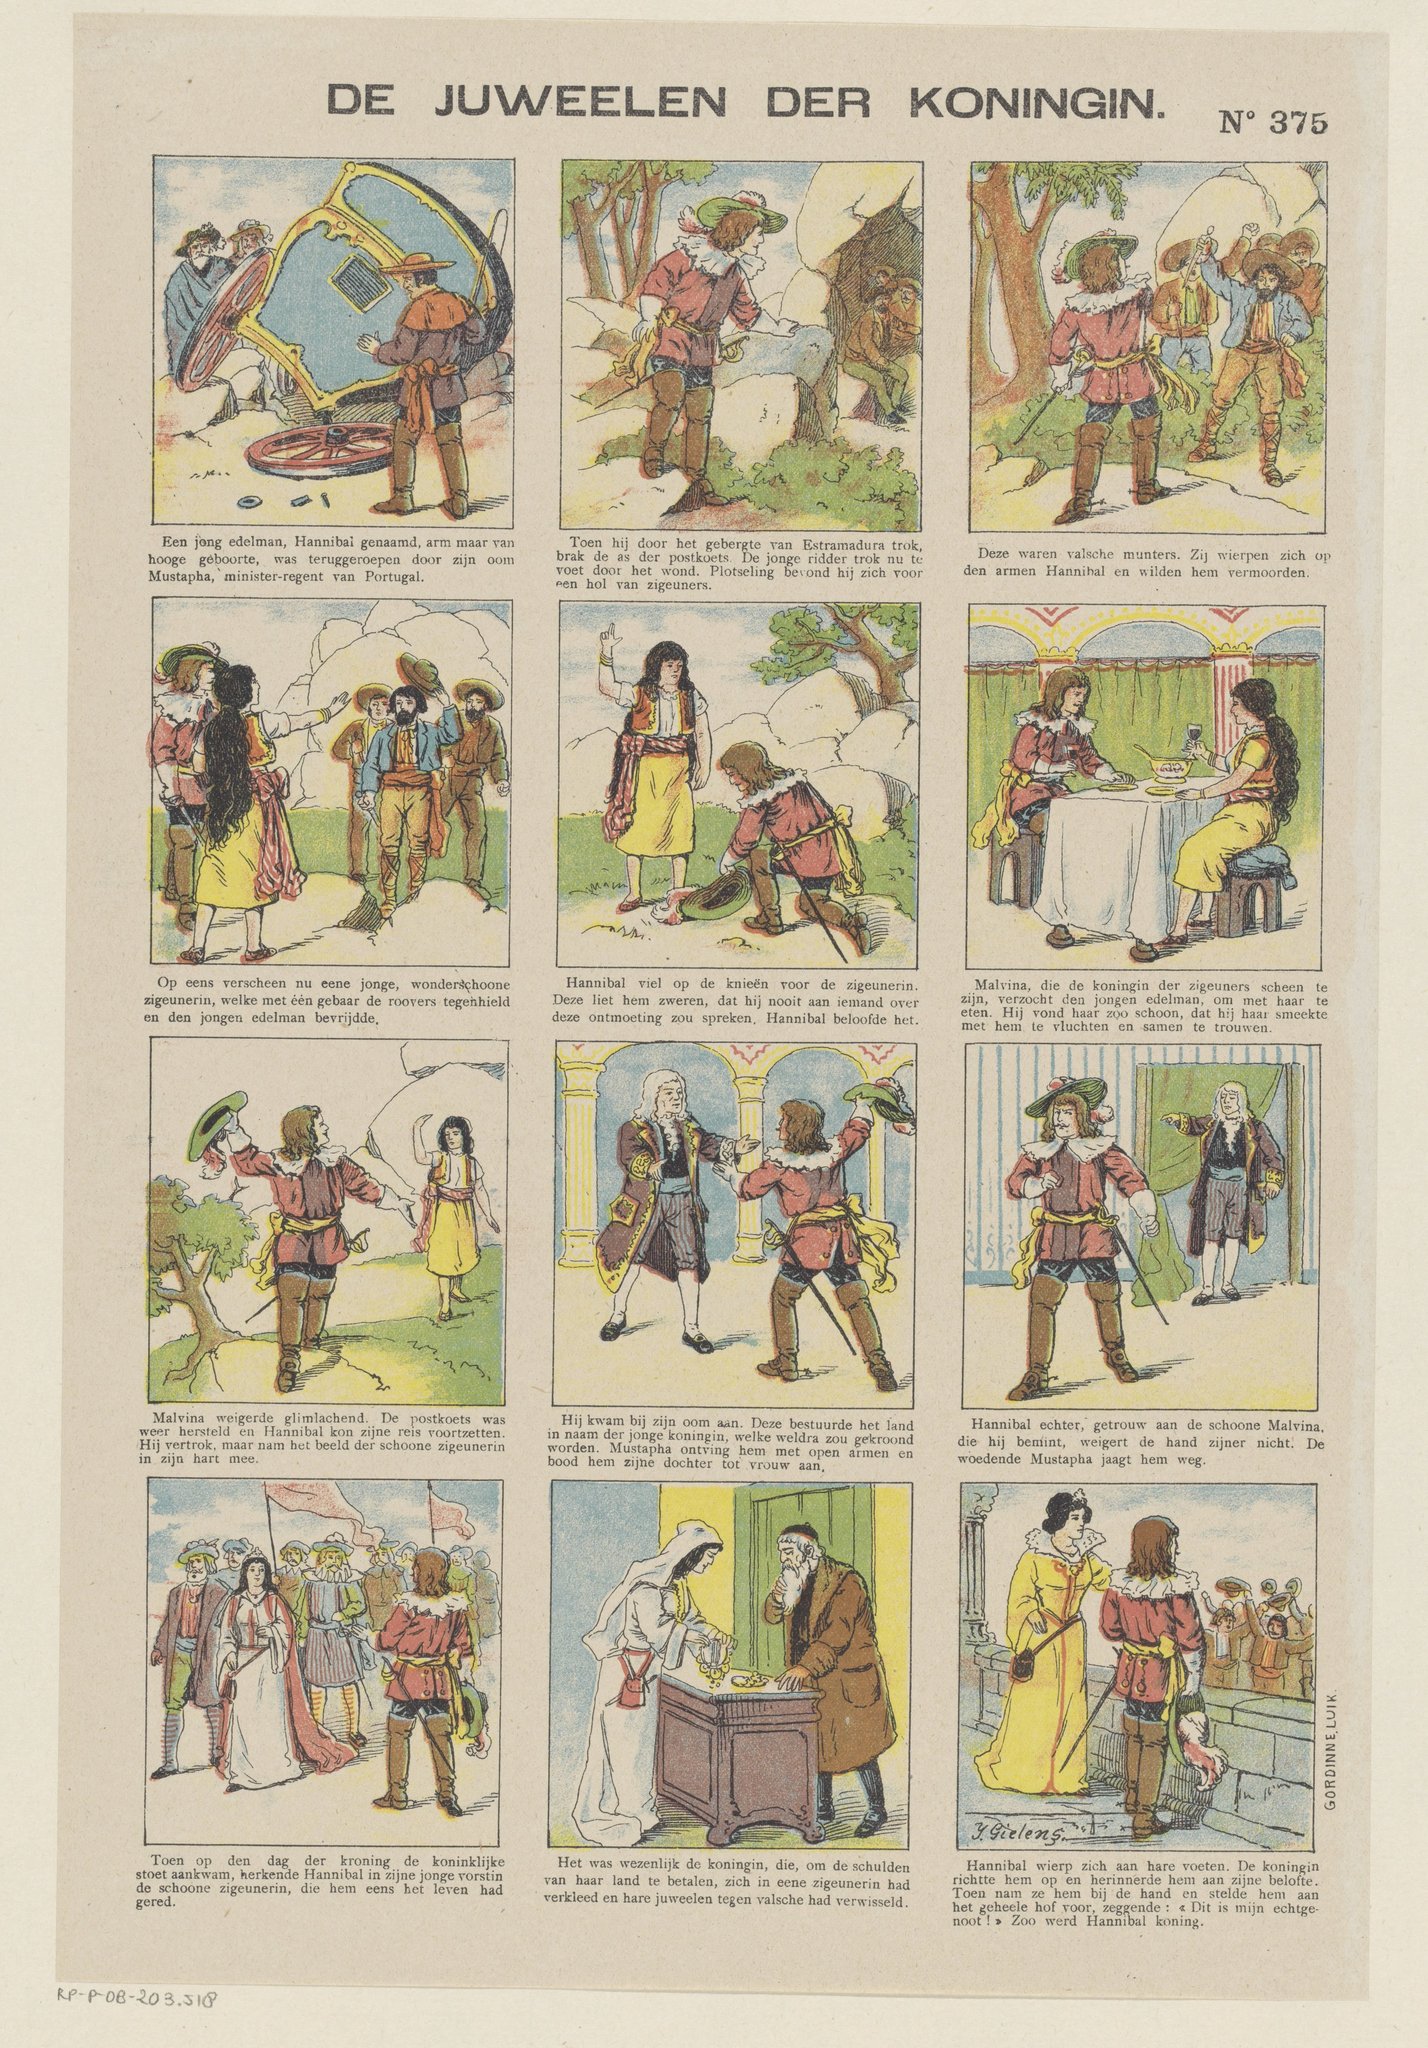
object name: popular print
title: De juweelen der koningin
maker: j. gielens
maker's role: print maker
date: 1894-1959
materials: paper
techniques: lithograph, letterpress printing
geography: liège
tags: coronation of a ruler, wandering communities: romani or roma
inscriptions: collector's mark: Lugt 2760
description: Blad met 12 voorstellingen over Hannibal die verliefd wordt op de koningin. Onder elke afbeelding een onderschrift. Genummerd rechtsboven: No 375.